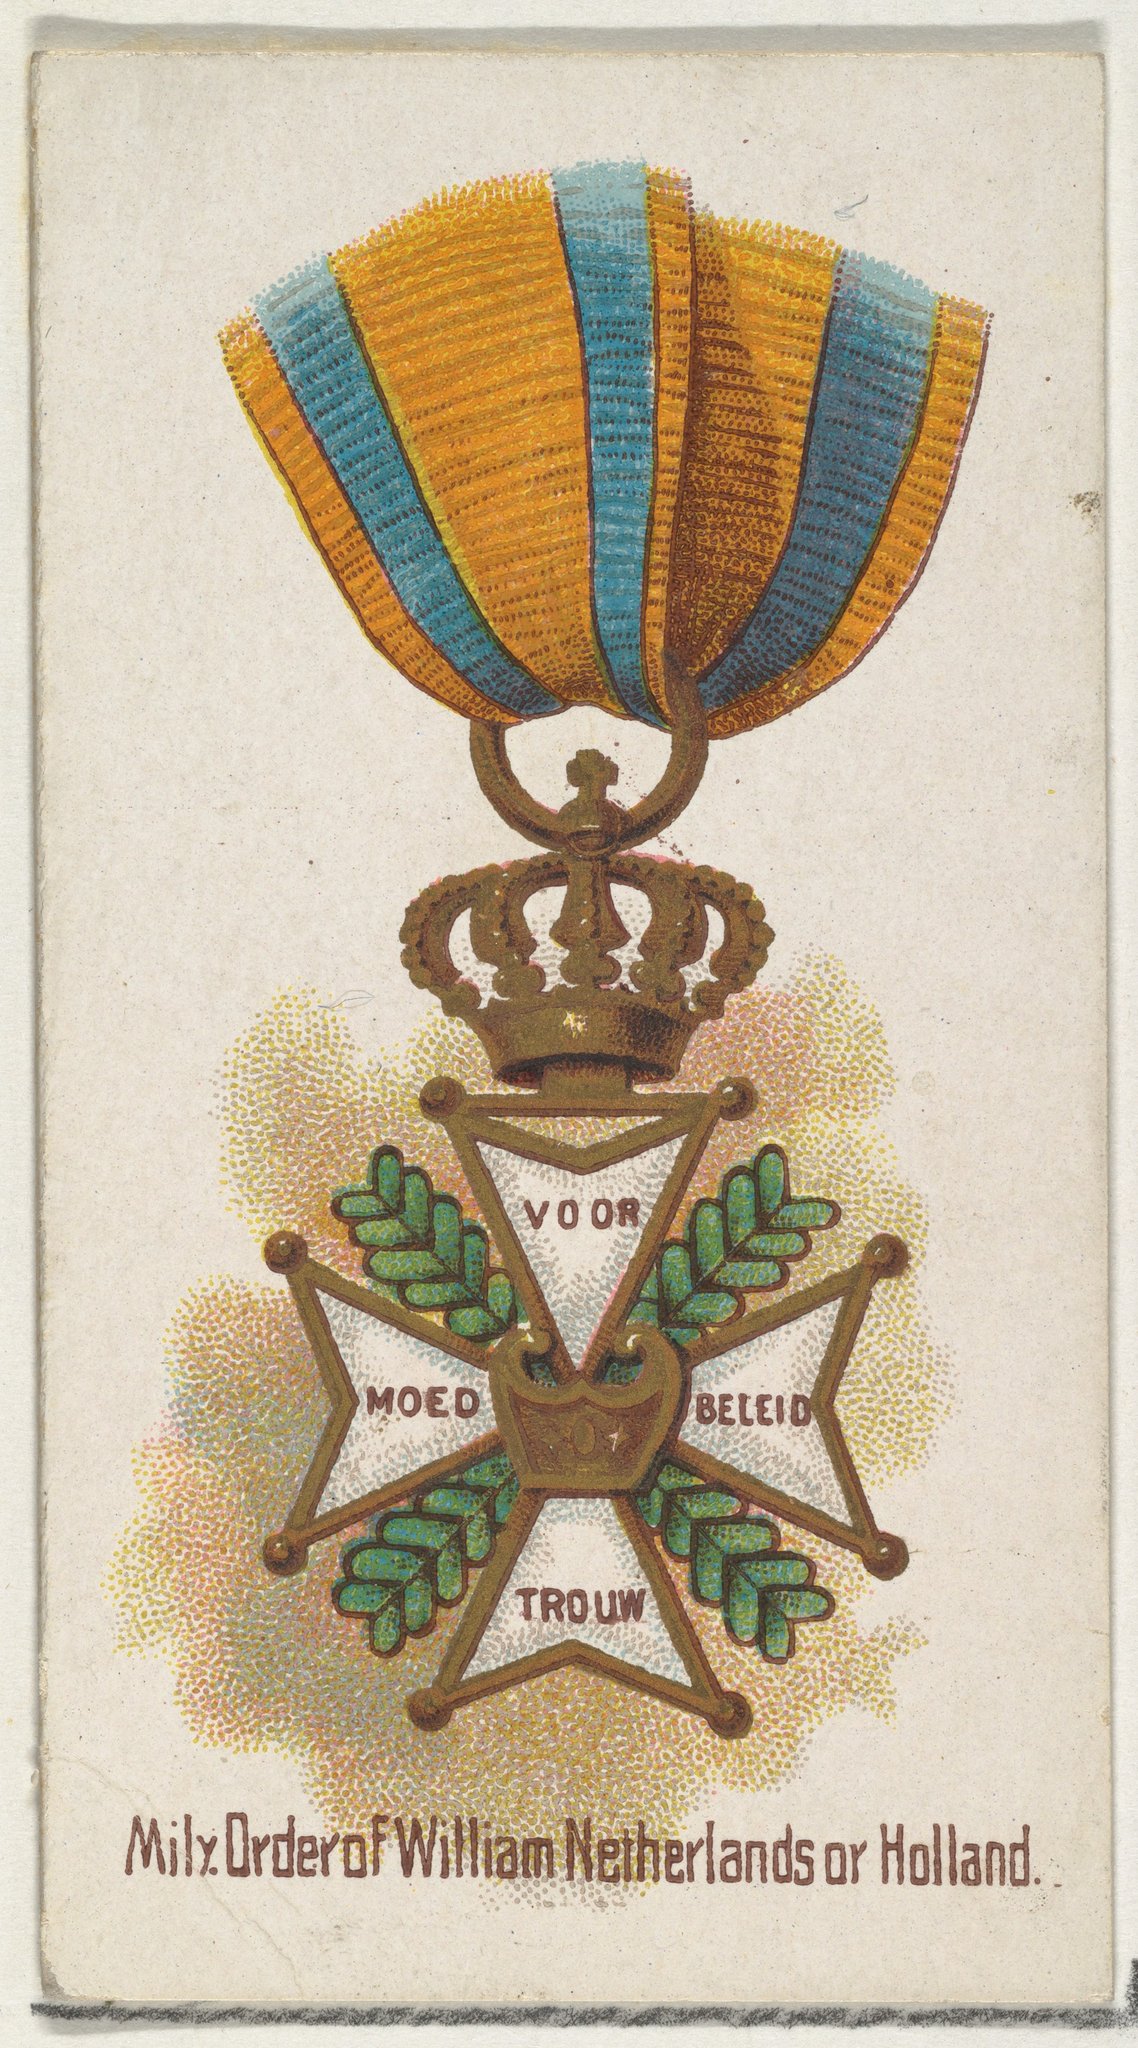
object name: print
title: Military Order of William Netherlands of Holland, from the World's Decorations series (N30) for Allen & Ginter Cigarettes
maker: allen & ginter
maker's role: publisher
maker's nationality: american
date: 1890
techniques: color lithograph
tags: medals